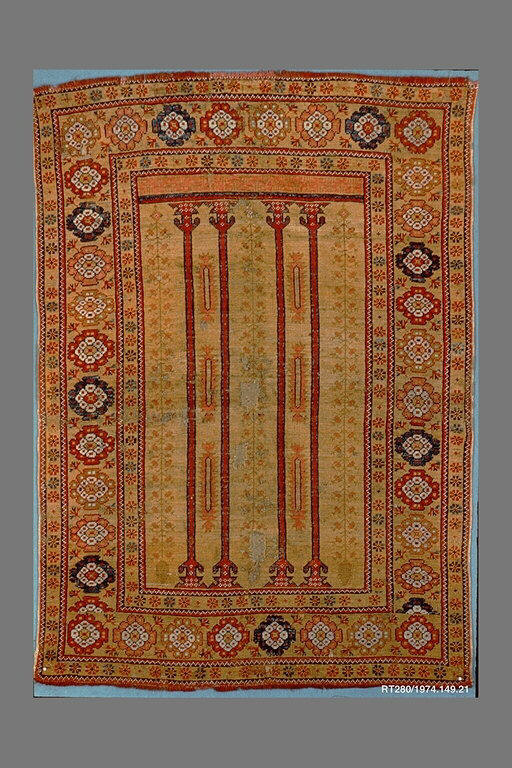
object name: carpet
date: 1701-1800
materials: wool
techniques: weave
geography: turkey